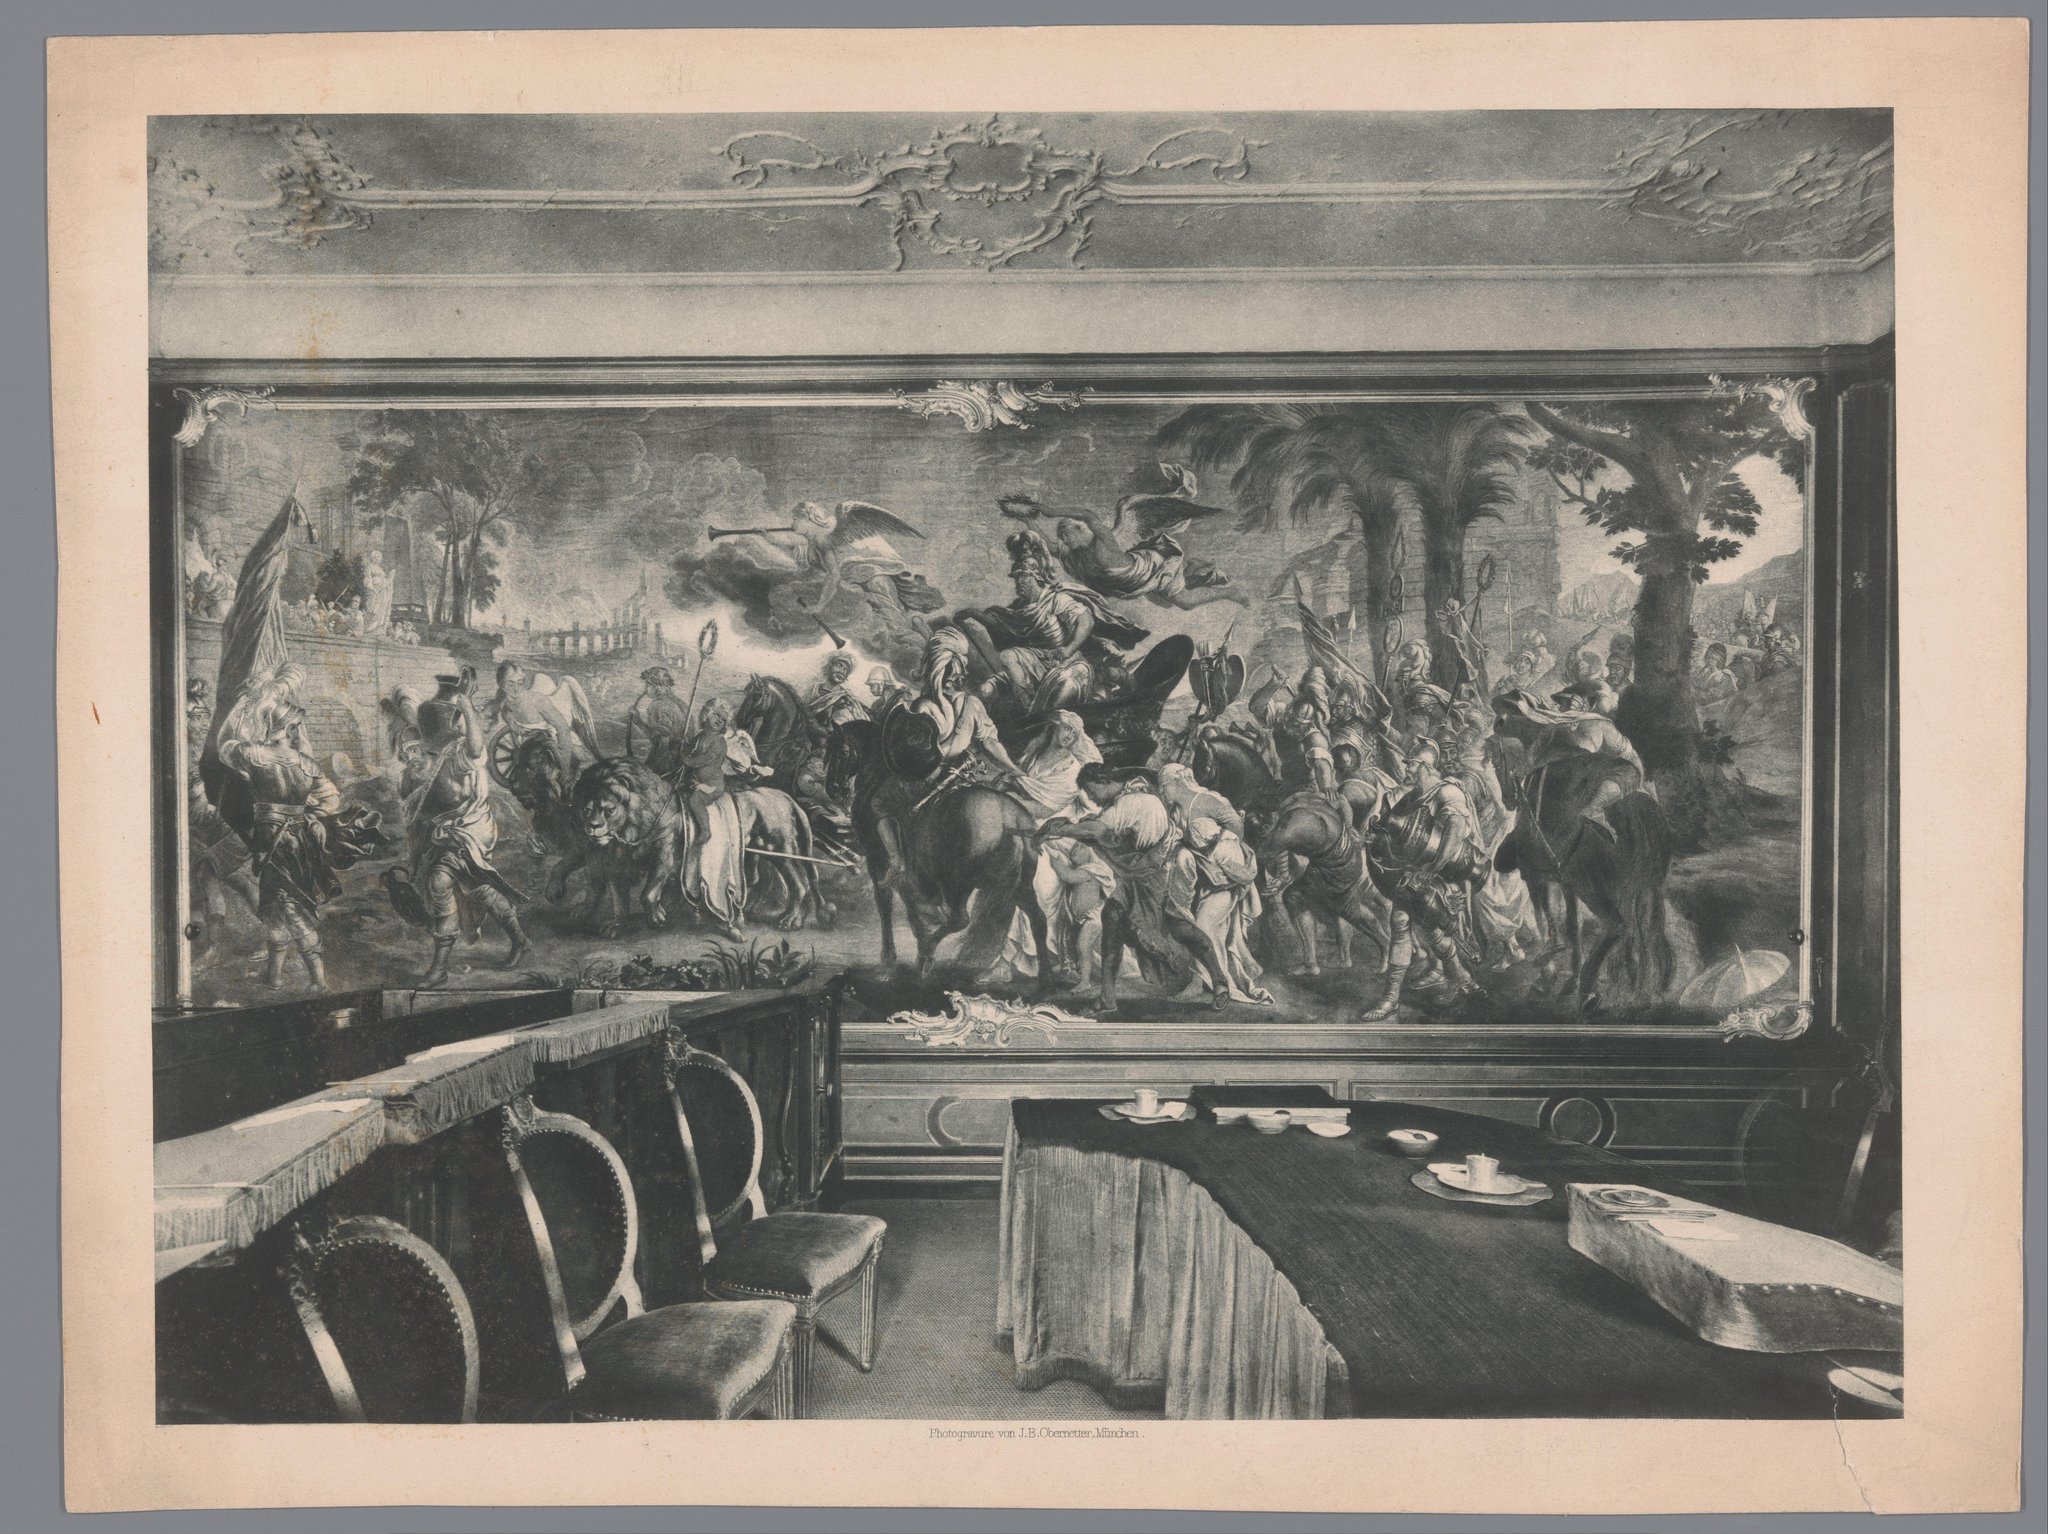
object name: photomechanical print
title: Zaal in het oude gerechtsgebouw te Middelburg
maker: johann baptist obernetter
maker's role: printer, publisher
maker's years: 1840-1887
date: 1867-1887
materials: paper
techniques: photoaquatint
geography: munich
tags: court building, tapestry, middelburg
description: Zaal van het voormalige gerechtsgebouw te Middelburg, het Van de Perrehuis.